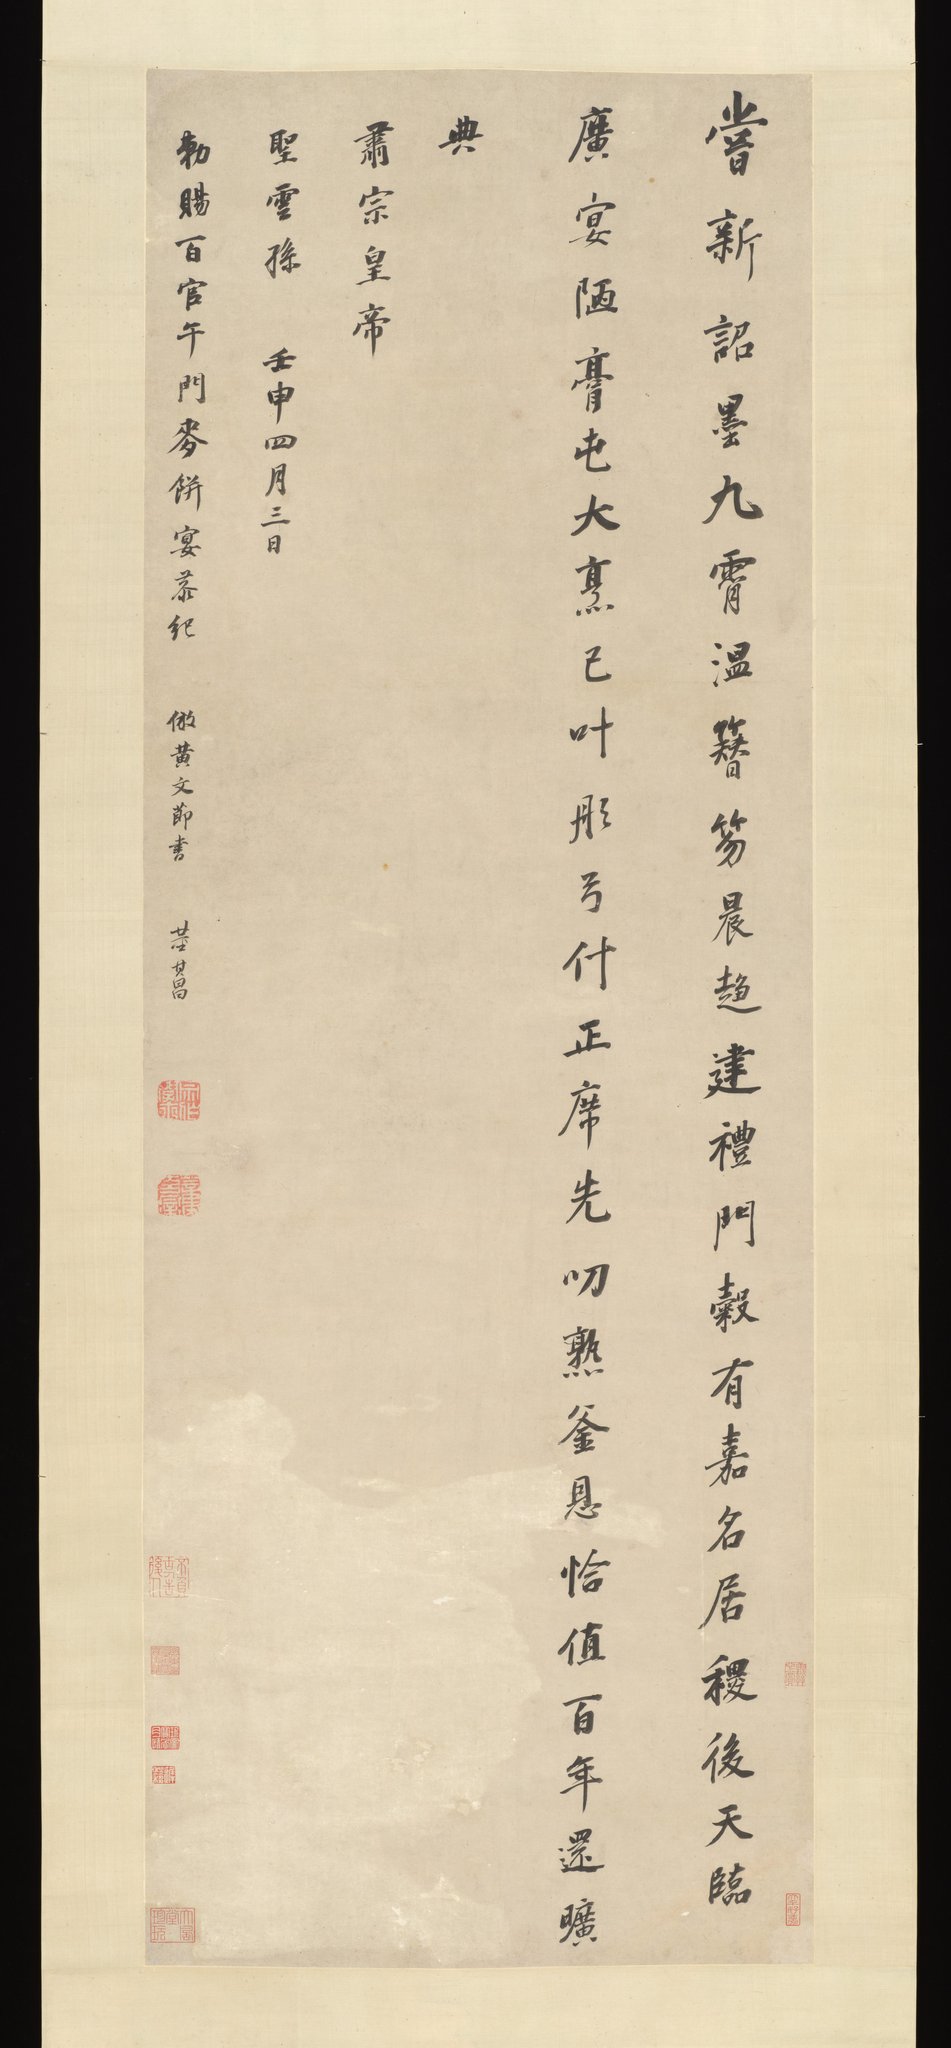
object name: hanging scroll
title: Poem Commemorating an Imperially Bestowed Feast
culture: chinese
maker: dong qichang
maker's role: artist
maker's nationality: chinese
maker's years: 1555-1636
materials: ink, paper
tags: poetry